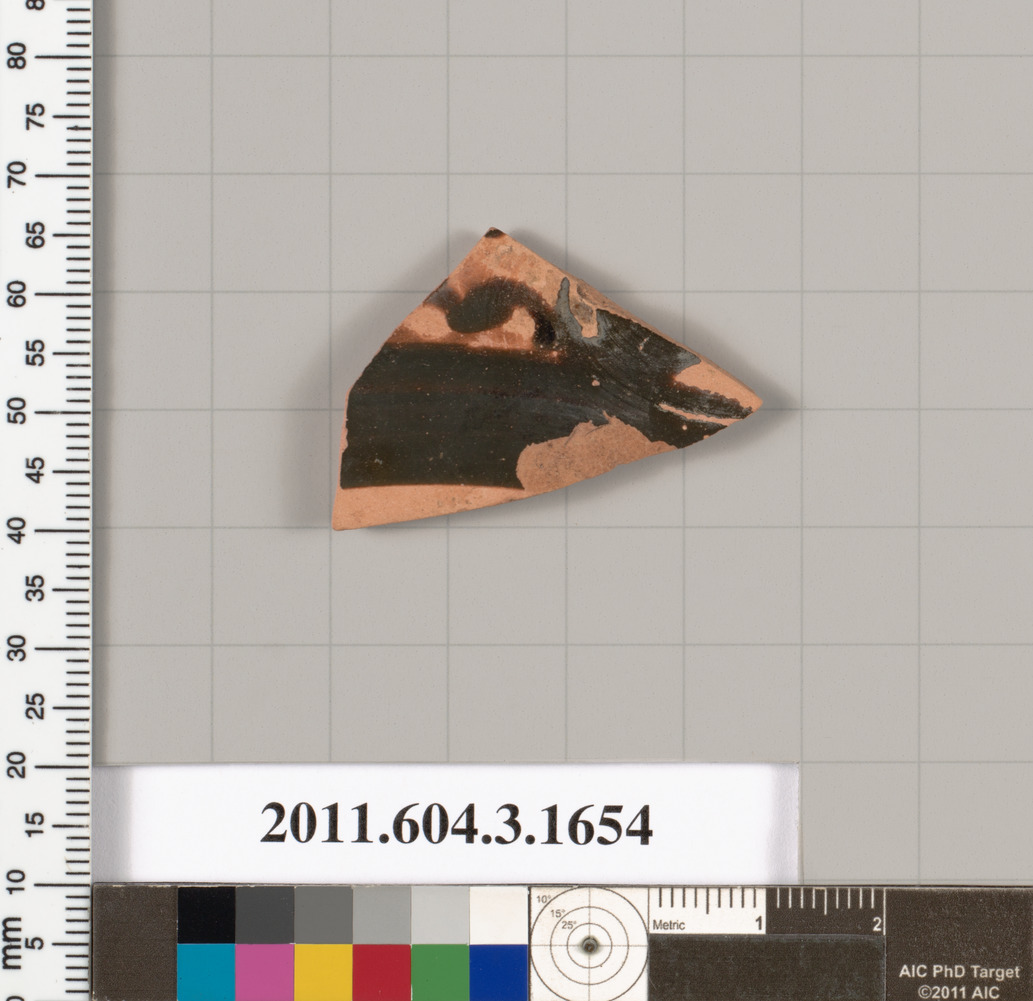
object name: kylix fragment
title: Terracotta fragment of a kylix: Band cup (drinking cup)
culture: greek, attic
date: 550-526 BCE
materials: terracotta